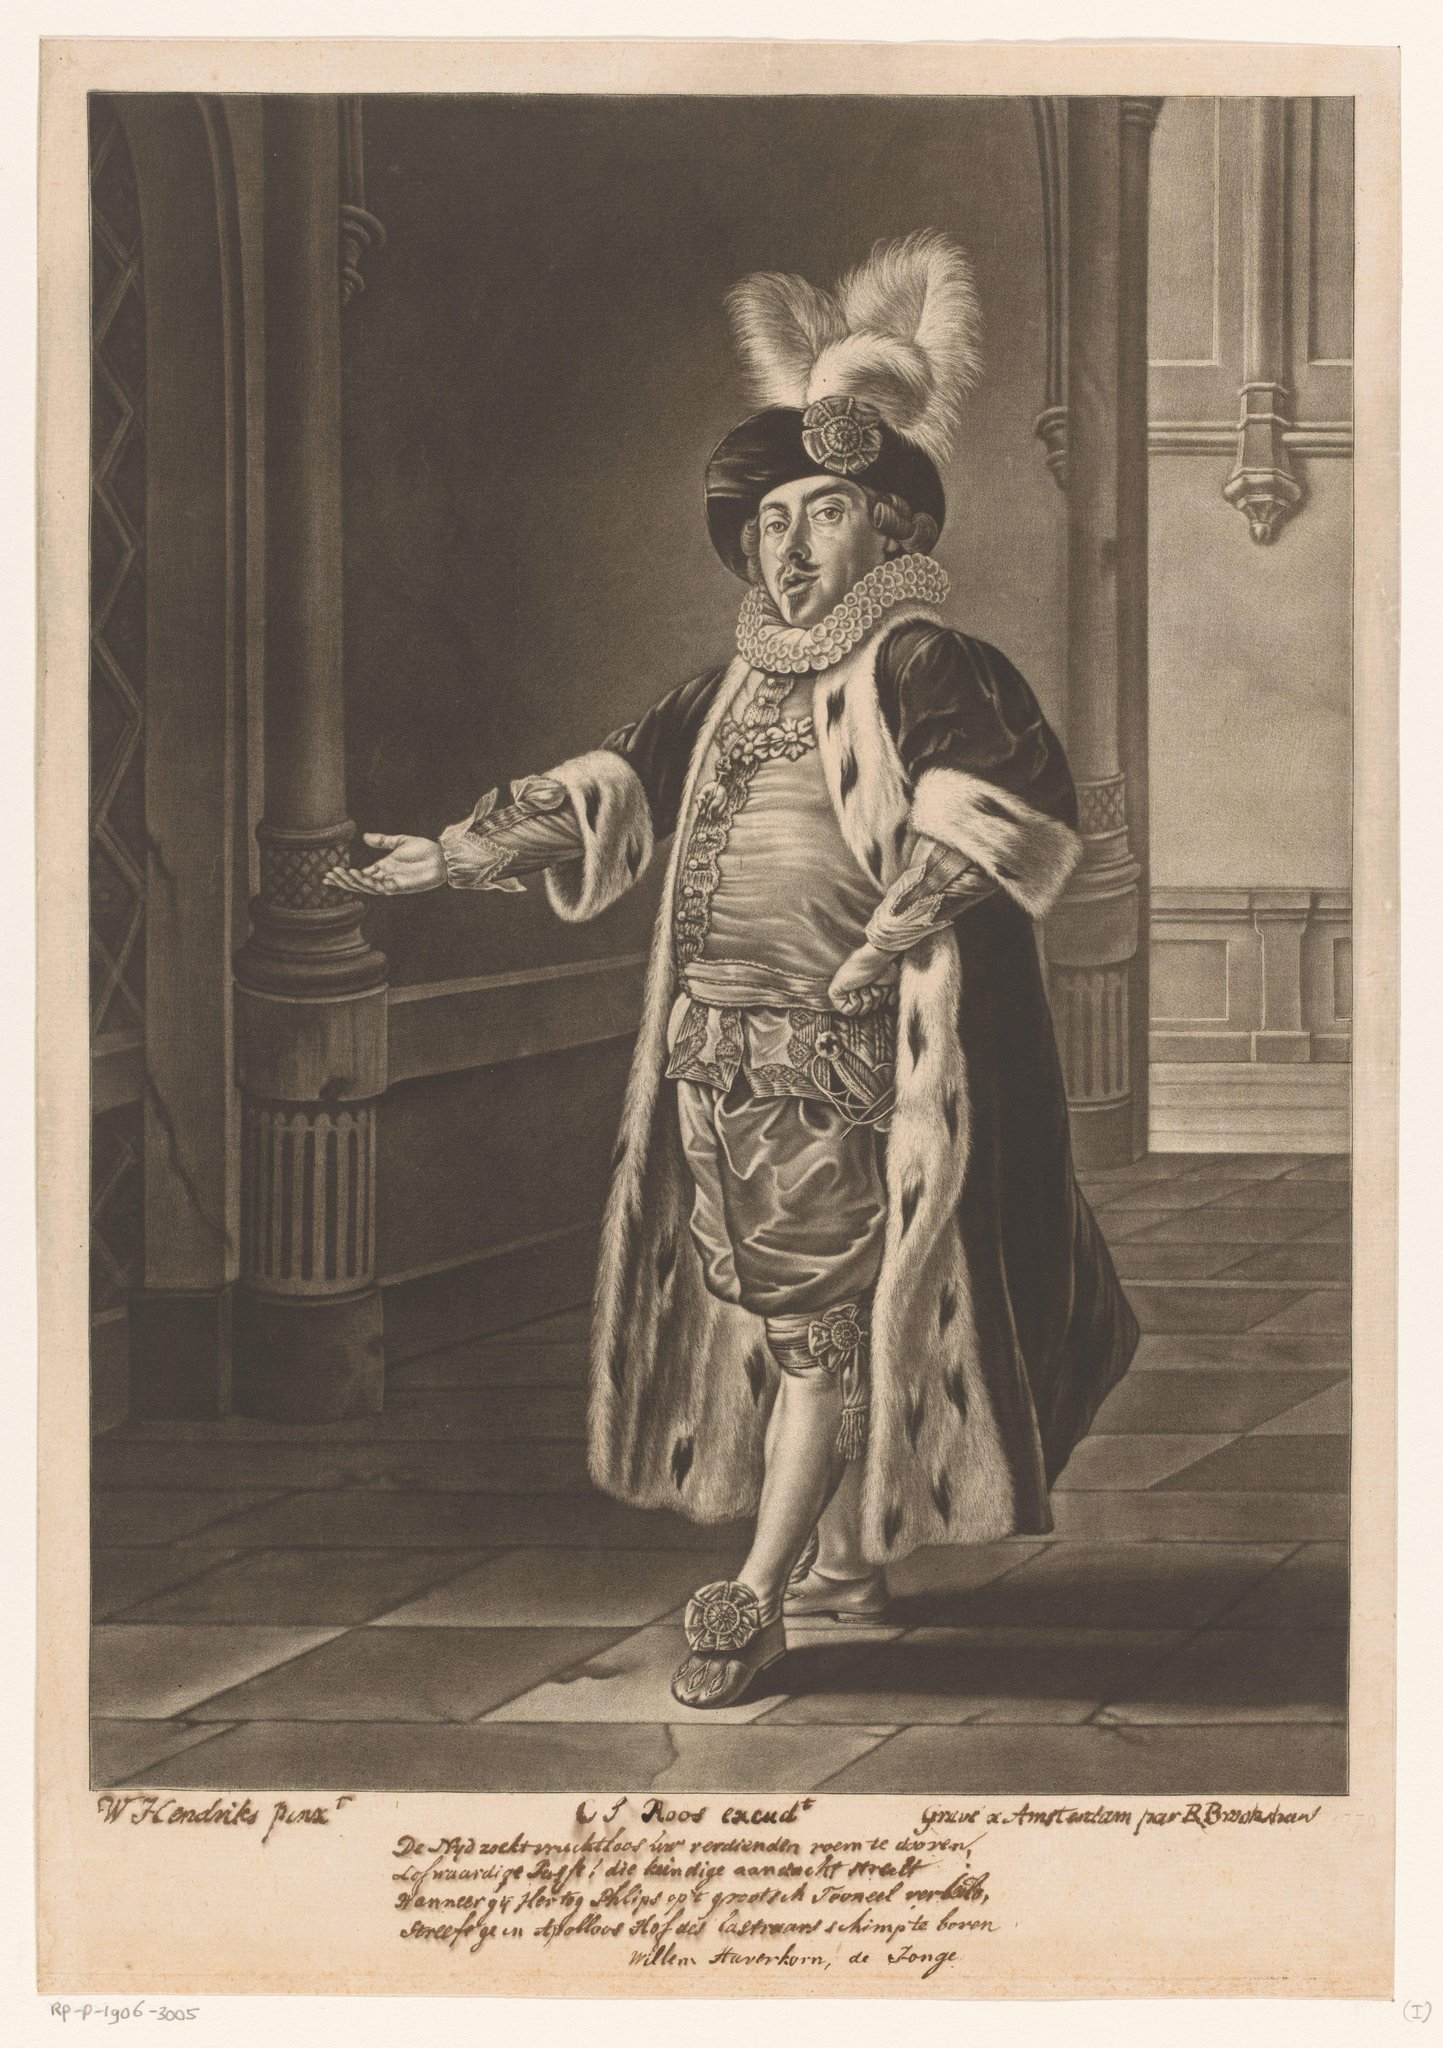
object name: print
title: Portret van Carel Passé als Filips de Goede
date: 1779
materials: paper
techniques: mezzotint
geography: amsterdam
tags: bruges, philip iii the good, historical persons, portrait of actor, actress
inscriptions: collector's mark: Lugt 2228, inscription: ‘W Hendriks pinxt CS Roos excudt Gravé a Amsterdam par R. Brookshaw’, inscription: ‘De Nijd zoekt vruchtloos uw verdienden roem te dooven, lofwaardige Passe! die kundige aandacht straalt [?] wanneer gij Hertog Philips op 't grootsch tooneel verbeeld, streeft ge in Apolloos Hof des Lastraars [?] schimp te boven. Willem Haverkorn, de Jonge’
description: Passé als Filips de Goede in het treurspel Jacoba van Beieren.